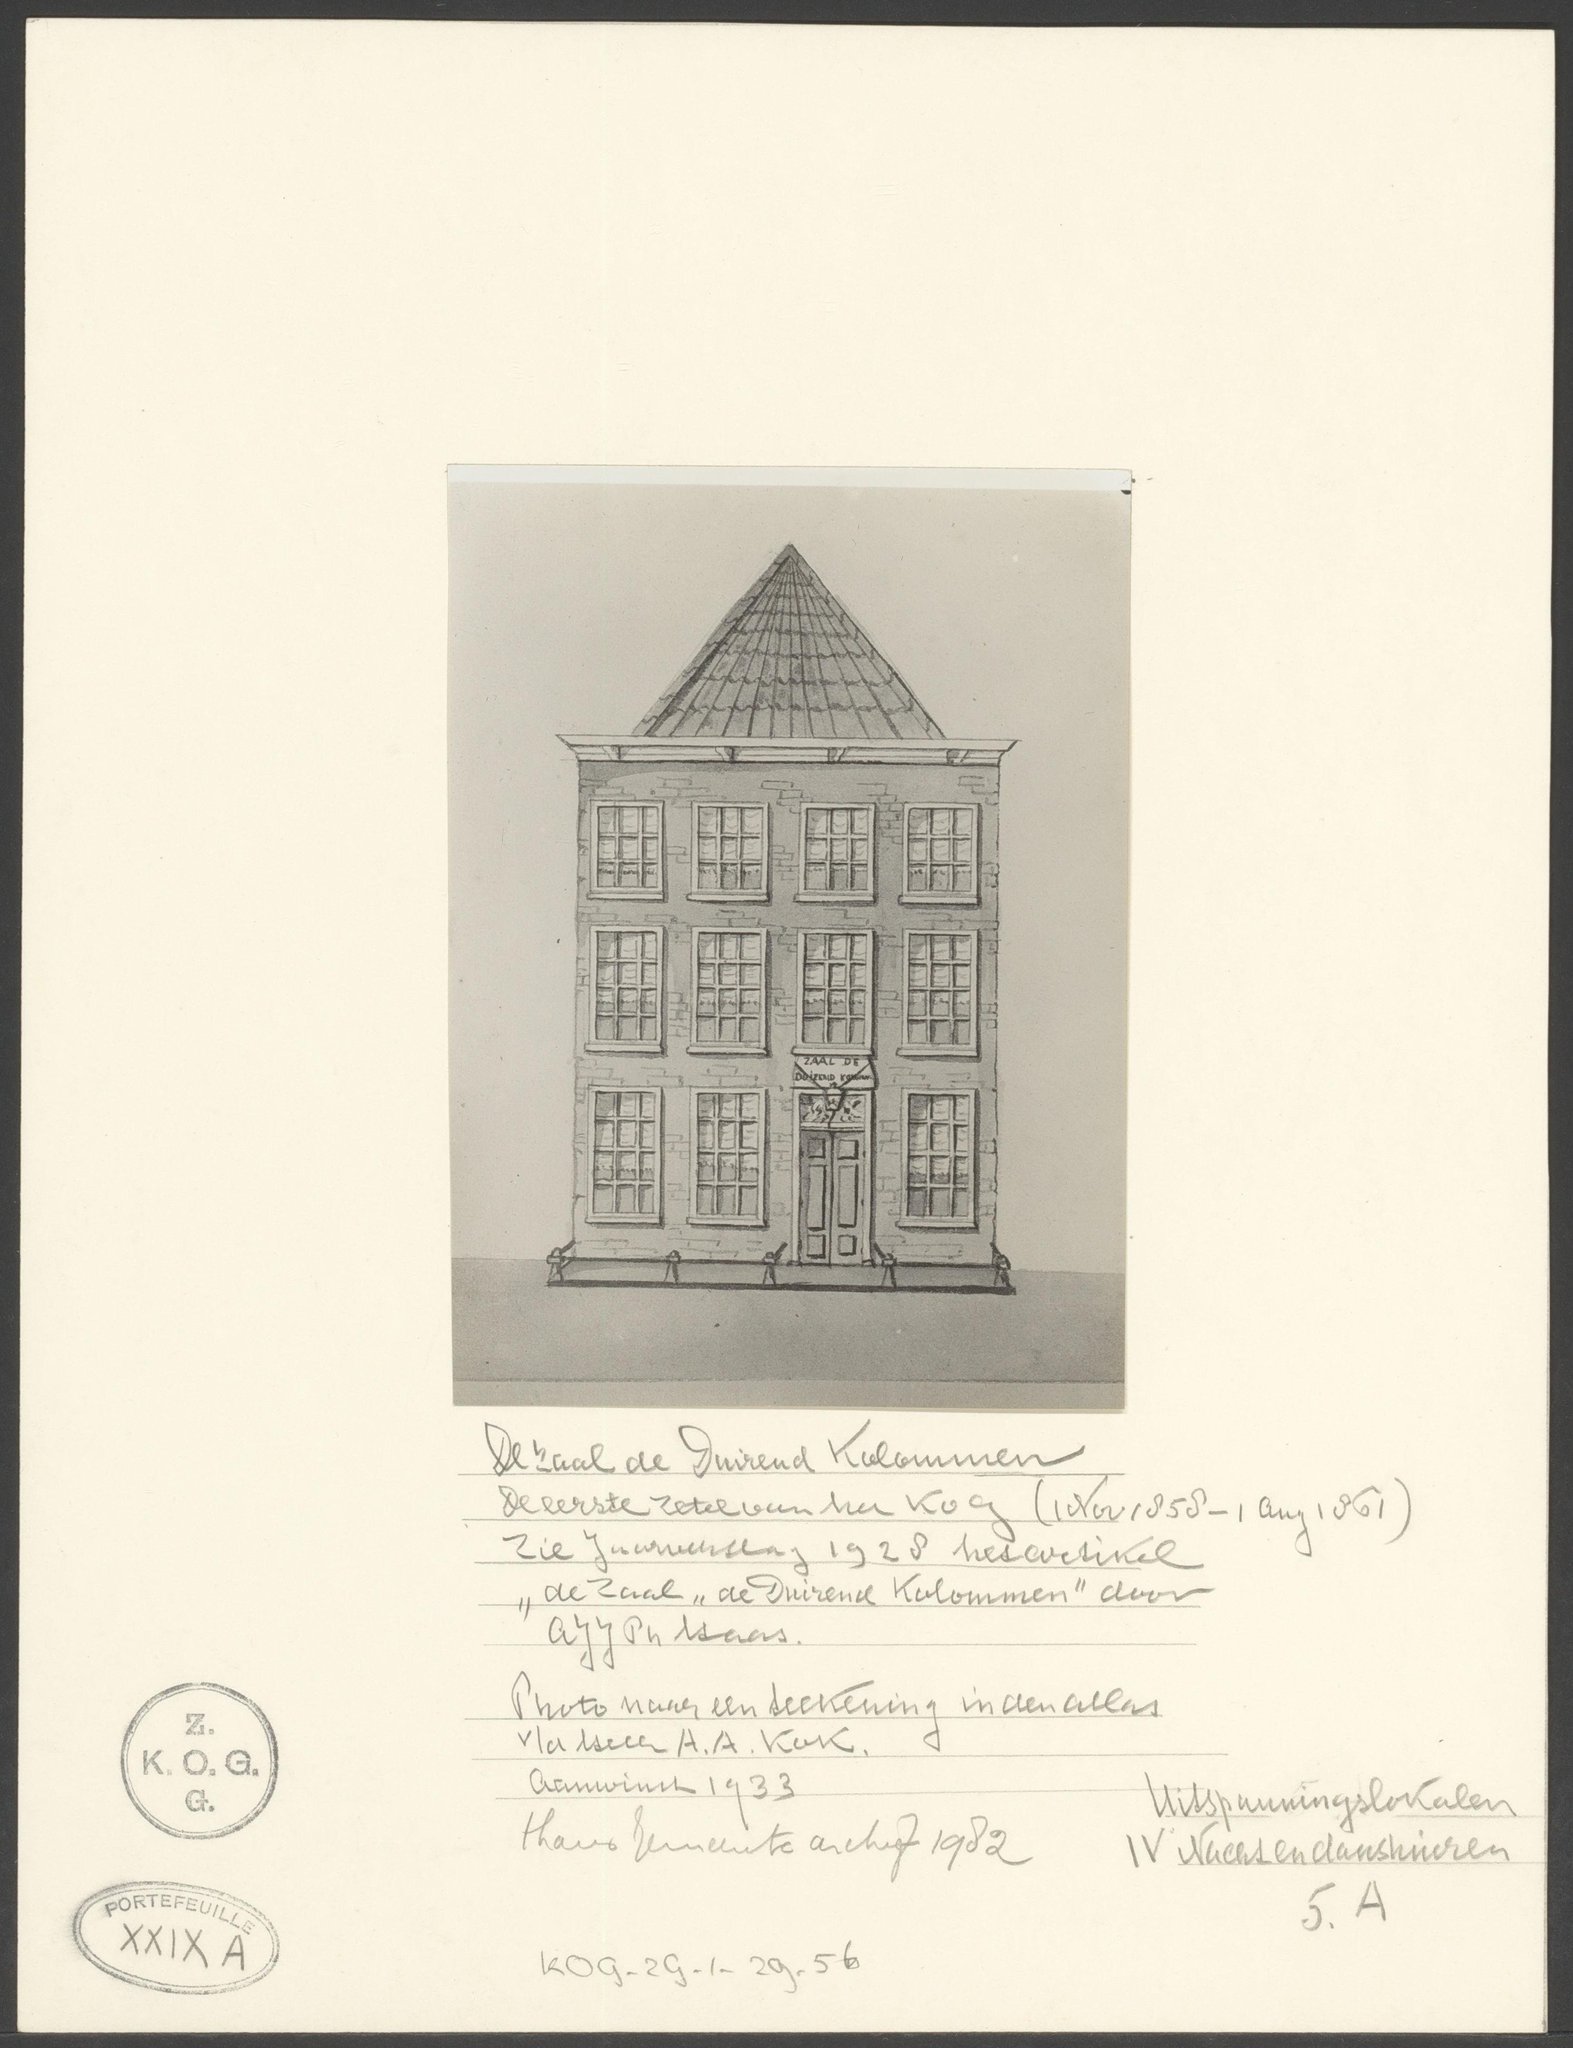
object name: photograph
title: Gezicht op De Zaal de Duizend Kolommen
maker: Anonymous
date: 1928-1933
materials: photographic support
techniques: gelatin silver print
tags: inn, coffee-house, public house, etc.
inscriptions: stamp, collector's mark: Lugt 1641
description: Onderwerpsrubrieken binnen de Atlas Zeden en Gewoonten: Zeden en gewoonten in engeren zin, Volksleven, Uitspanningslokalen, Nacht- en danshuizen.